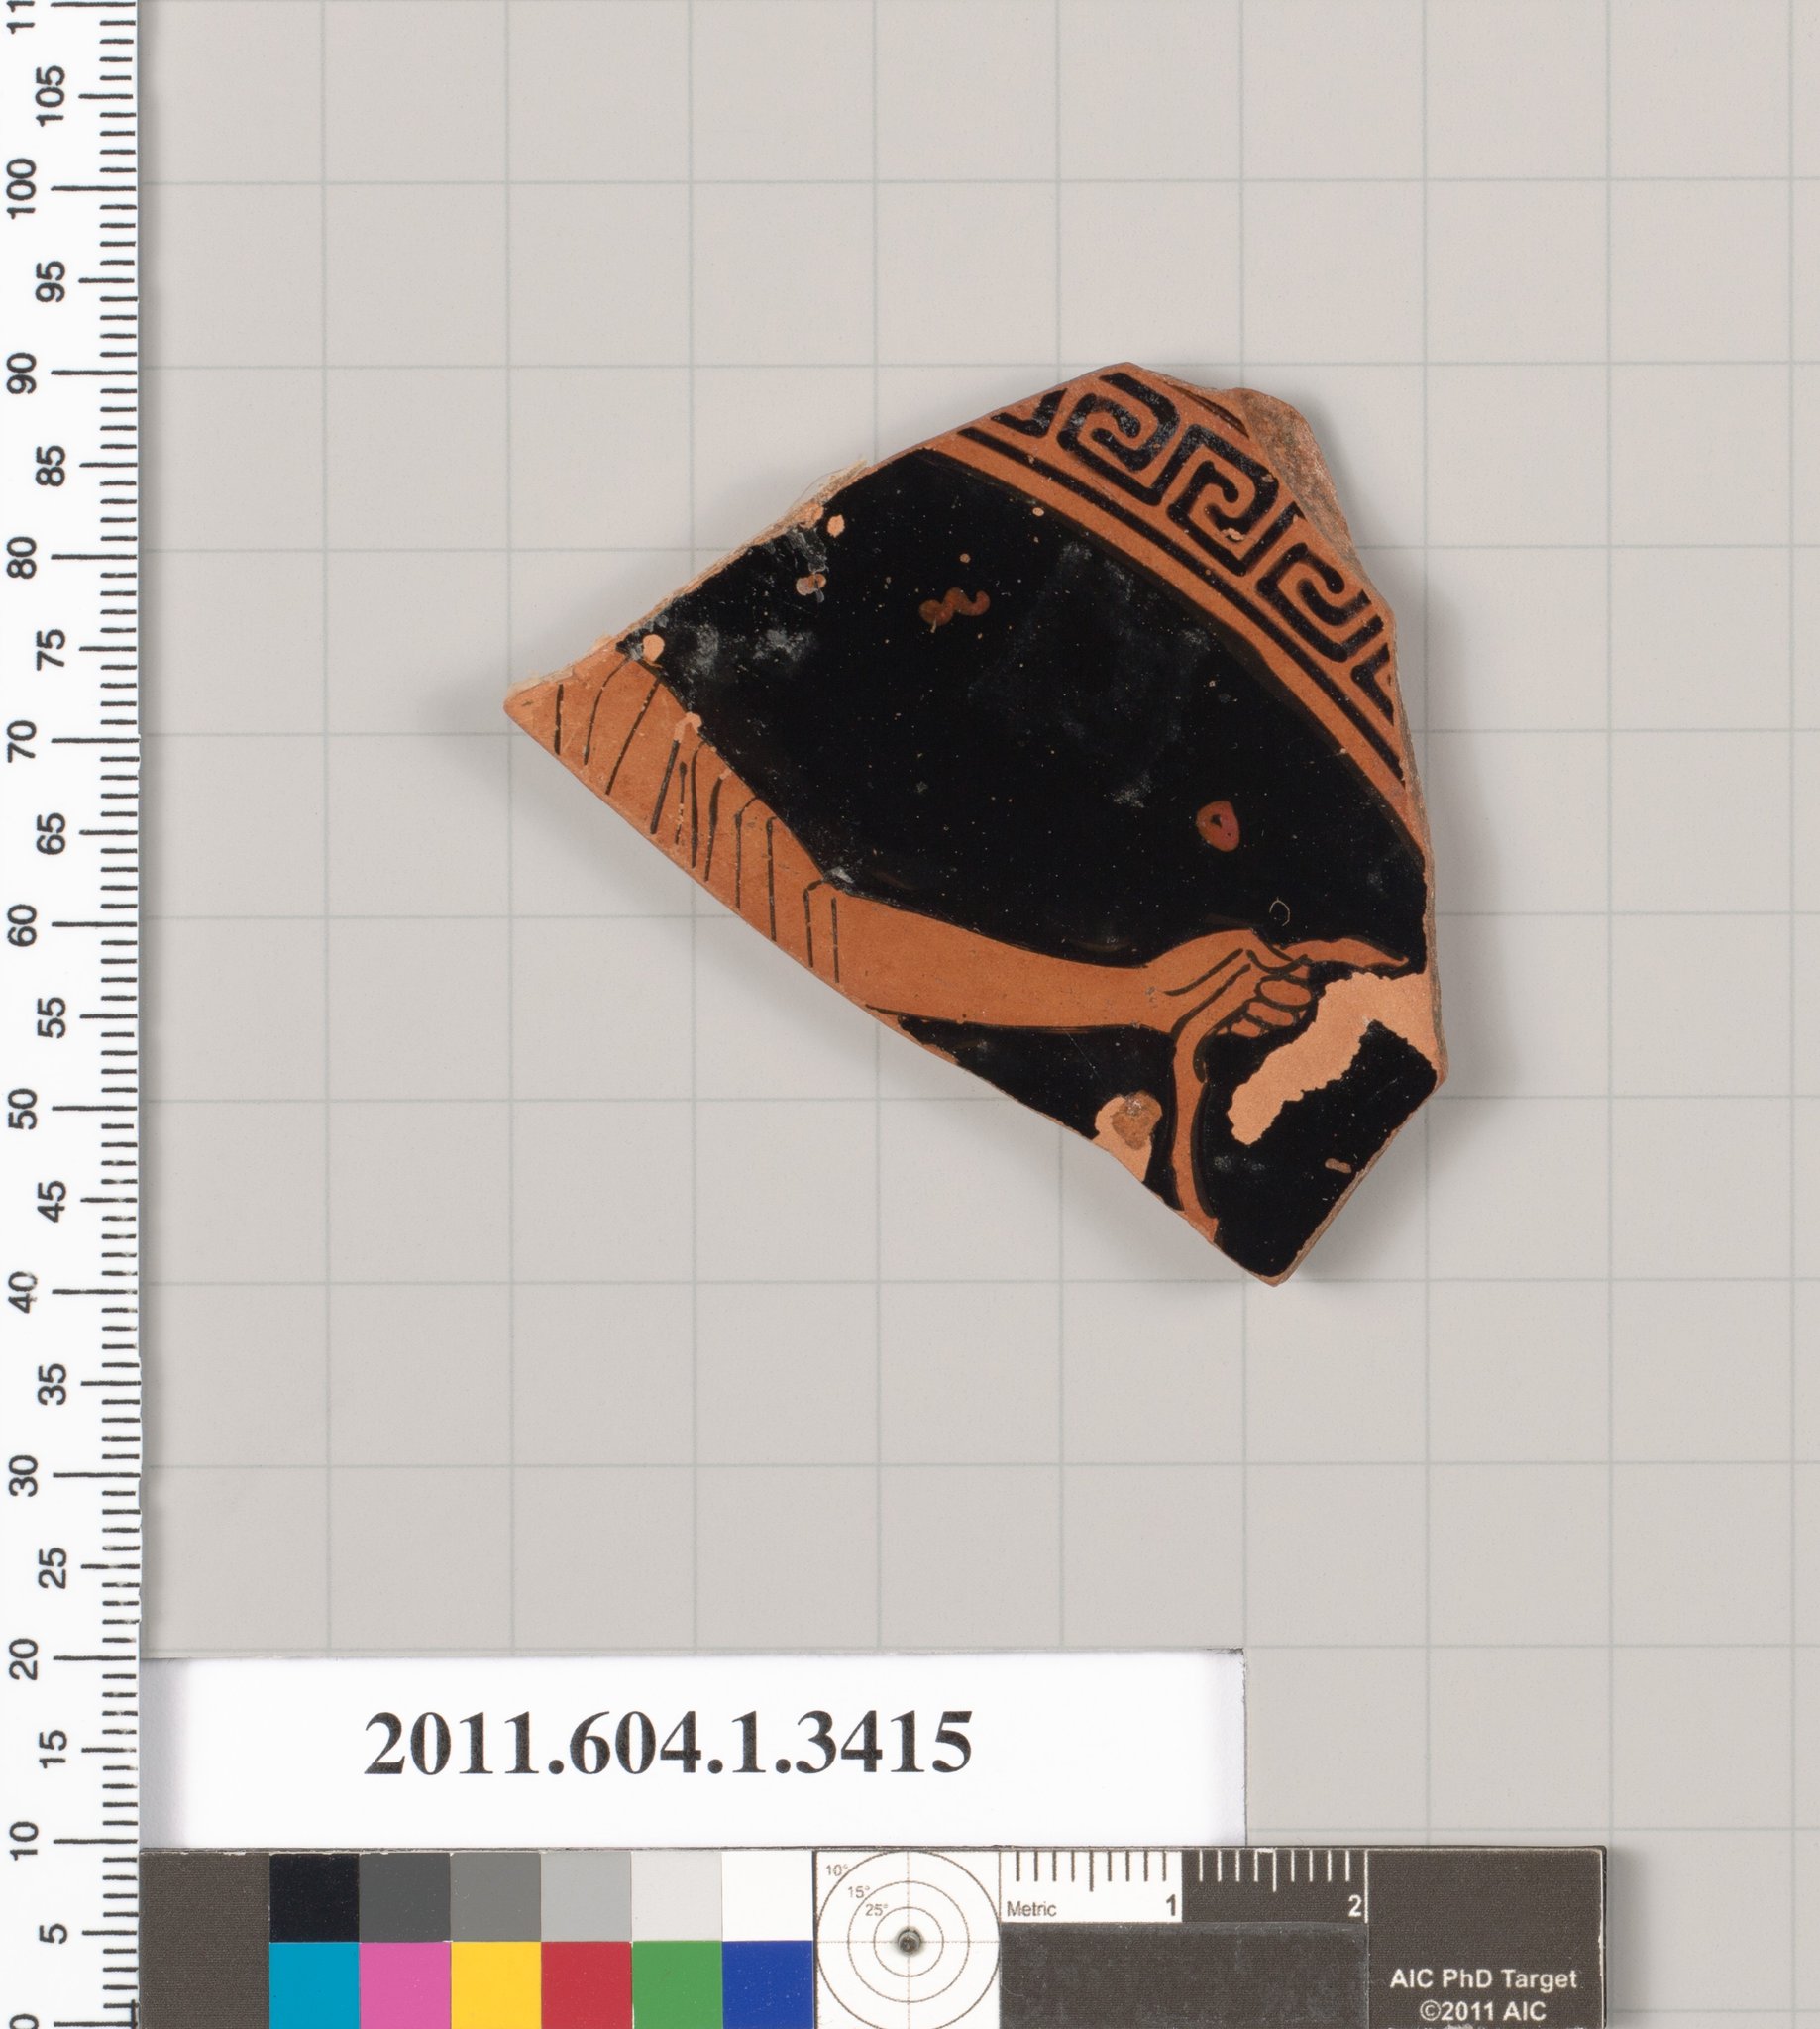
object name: kylix fragment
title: Terracotta fragment of a kylix (drinking cup)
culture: greek, attic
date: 490-470 BCE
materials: terracotta